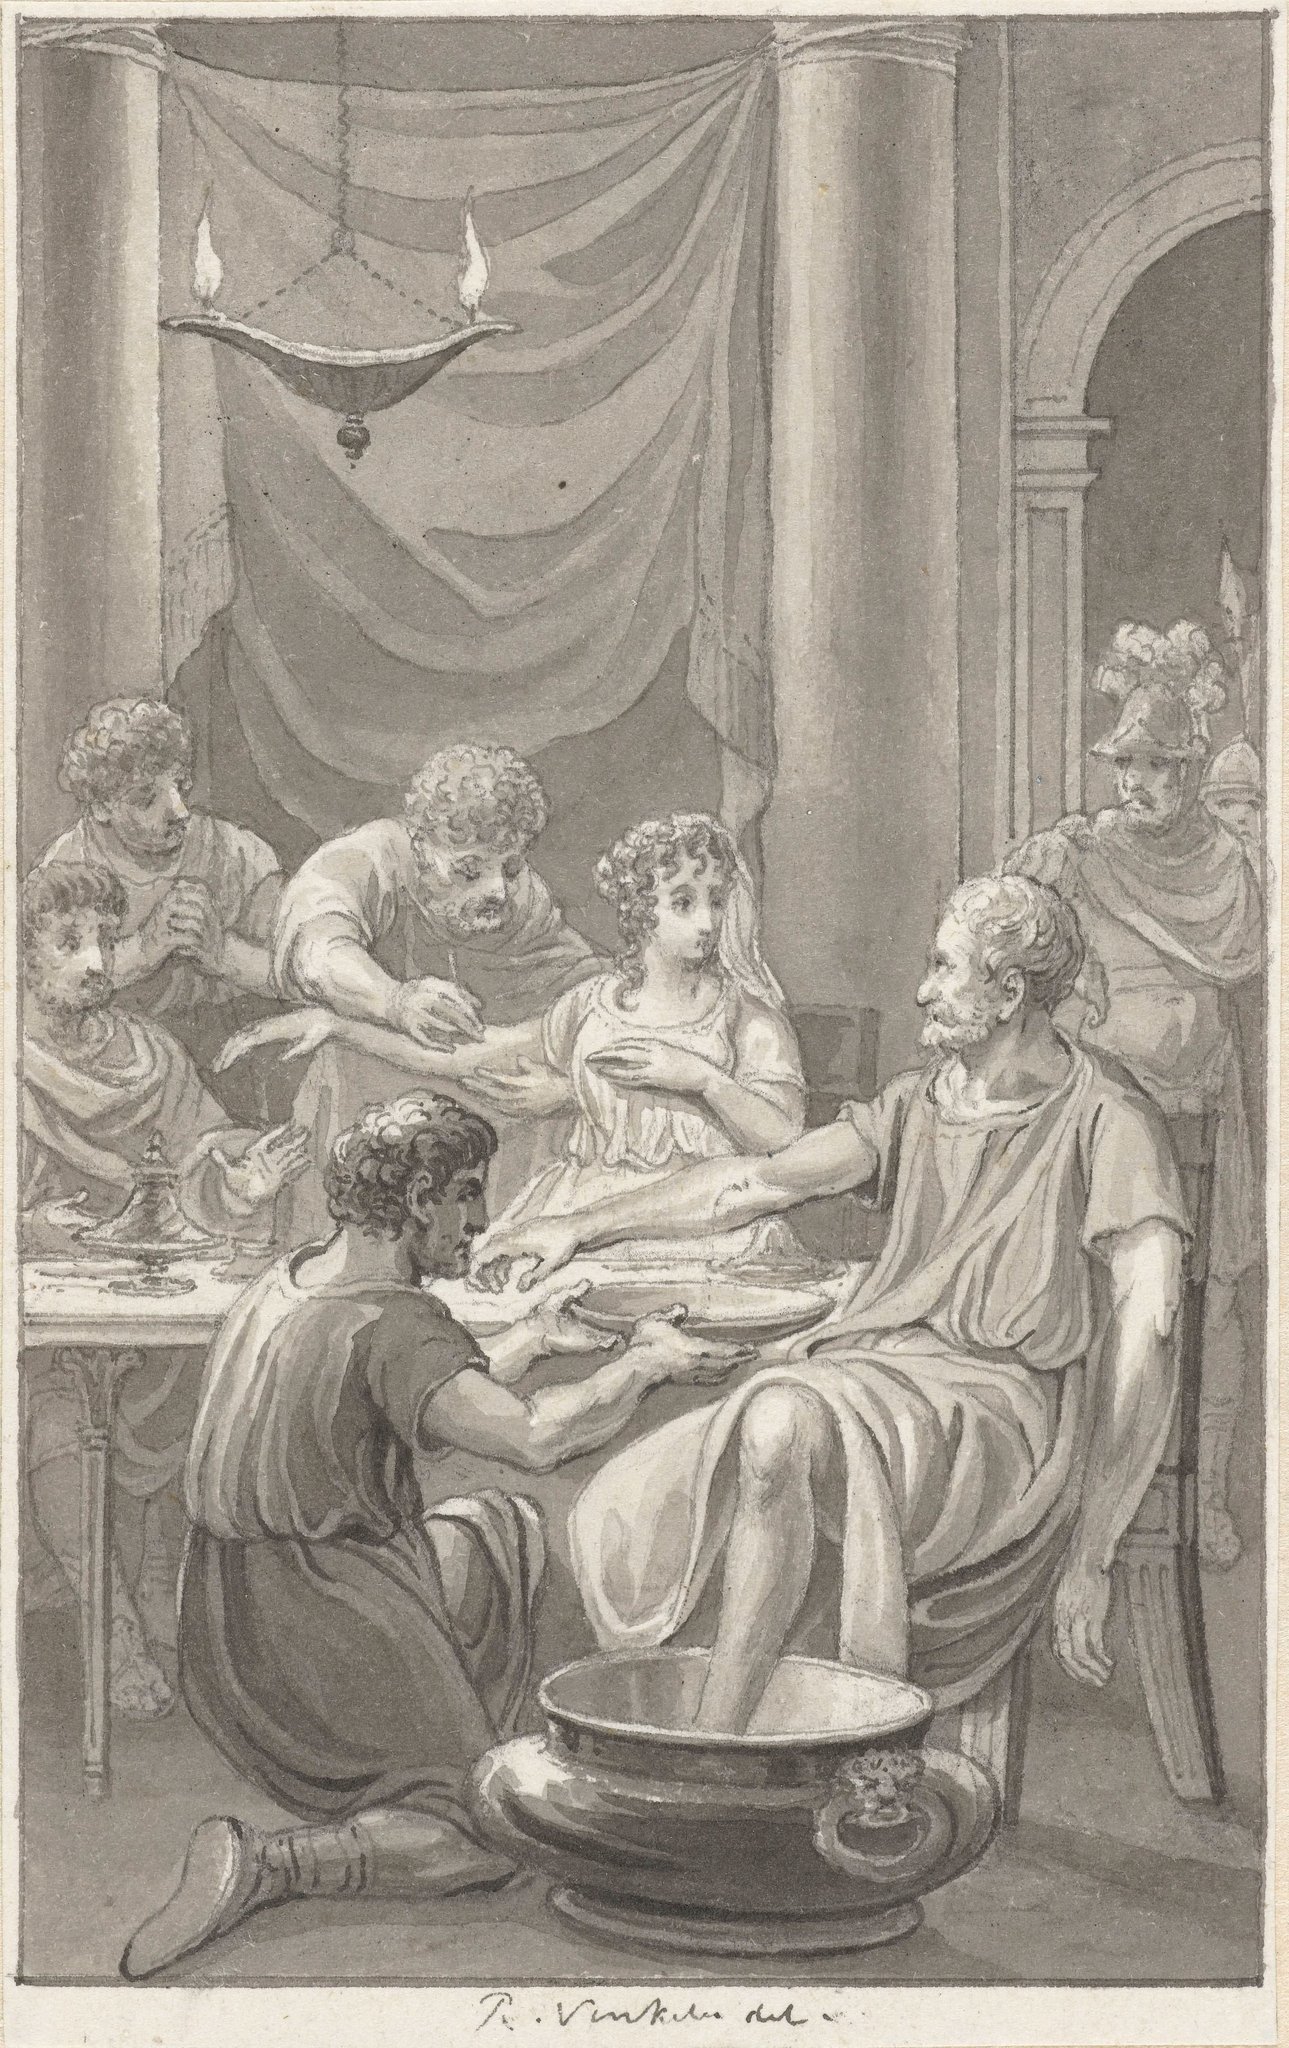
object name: drawing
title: De zelfmoord van Seneca en zijn vrouw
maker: reinier vinkeles (i)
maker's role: draughtsman, print maker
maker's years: 1741-1816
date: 1804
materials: ink, paper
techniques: brush, pen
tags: lucius annaeus seneca, death of seneca: at nero's order he cuts his veins, usually sitting in a basin or bath of water, and then takes a dose of poison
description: Ontwerp voor gravure door Ludwig Portman in M. Stuart's `Romeinsche Geschiedenissen', 1804, dl. 24 t.o. p. 164.